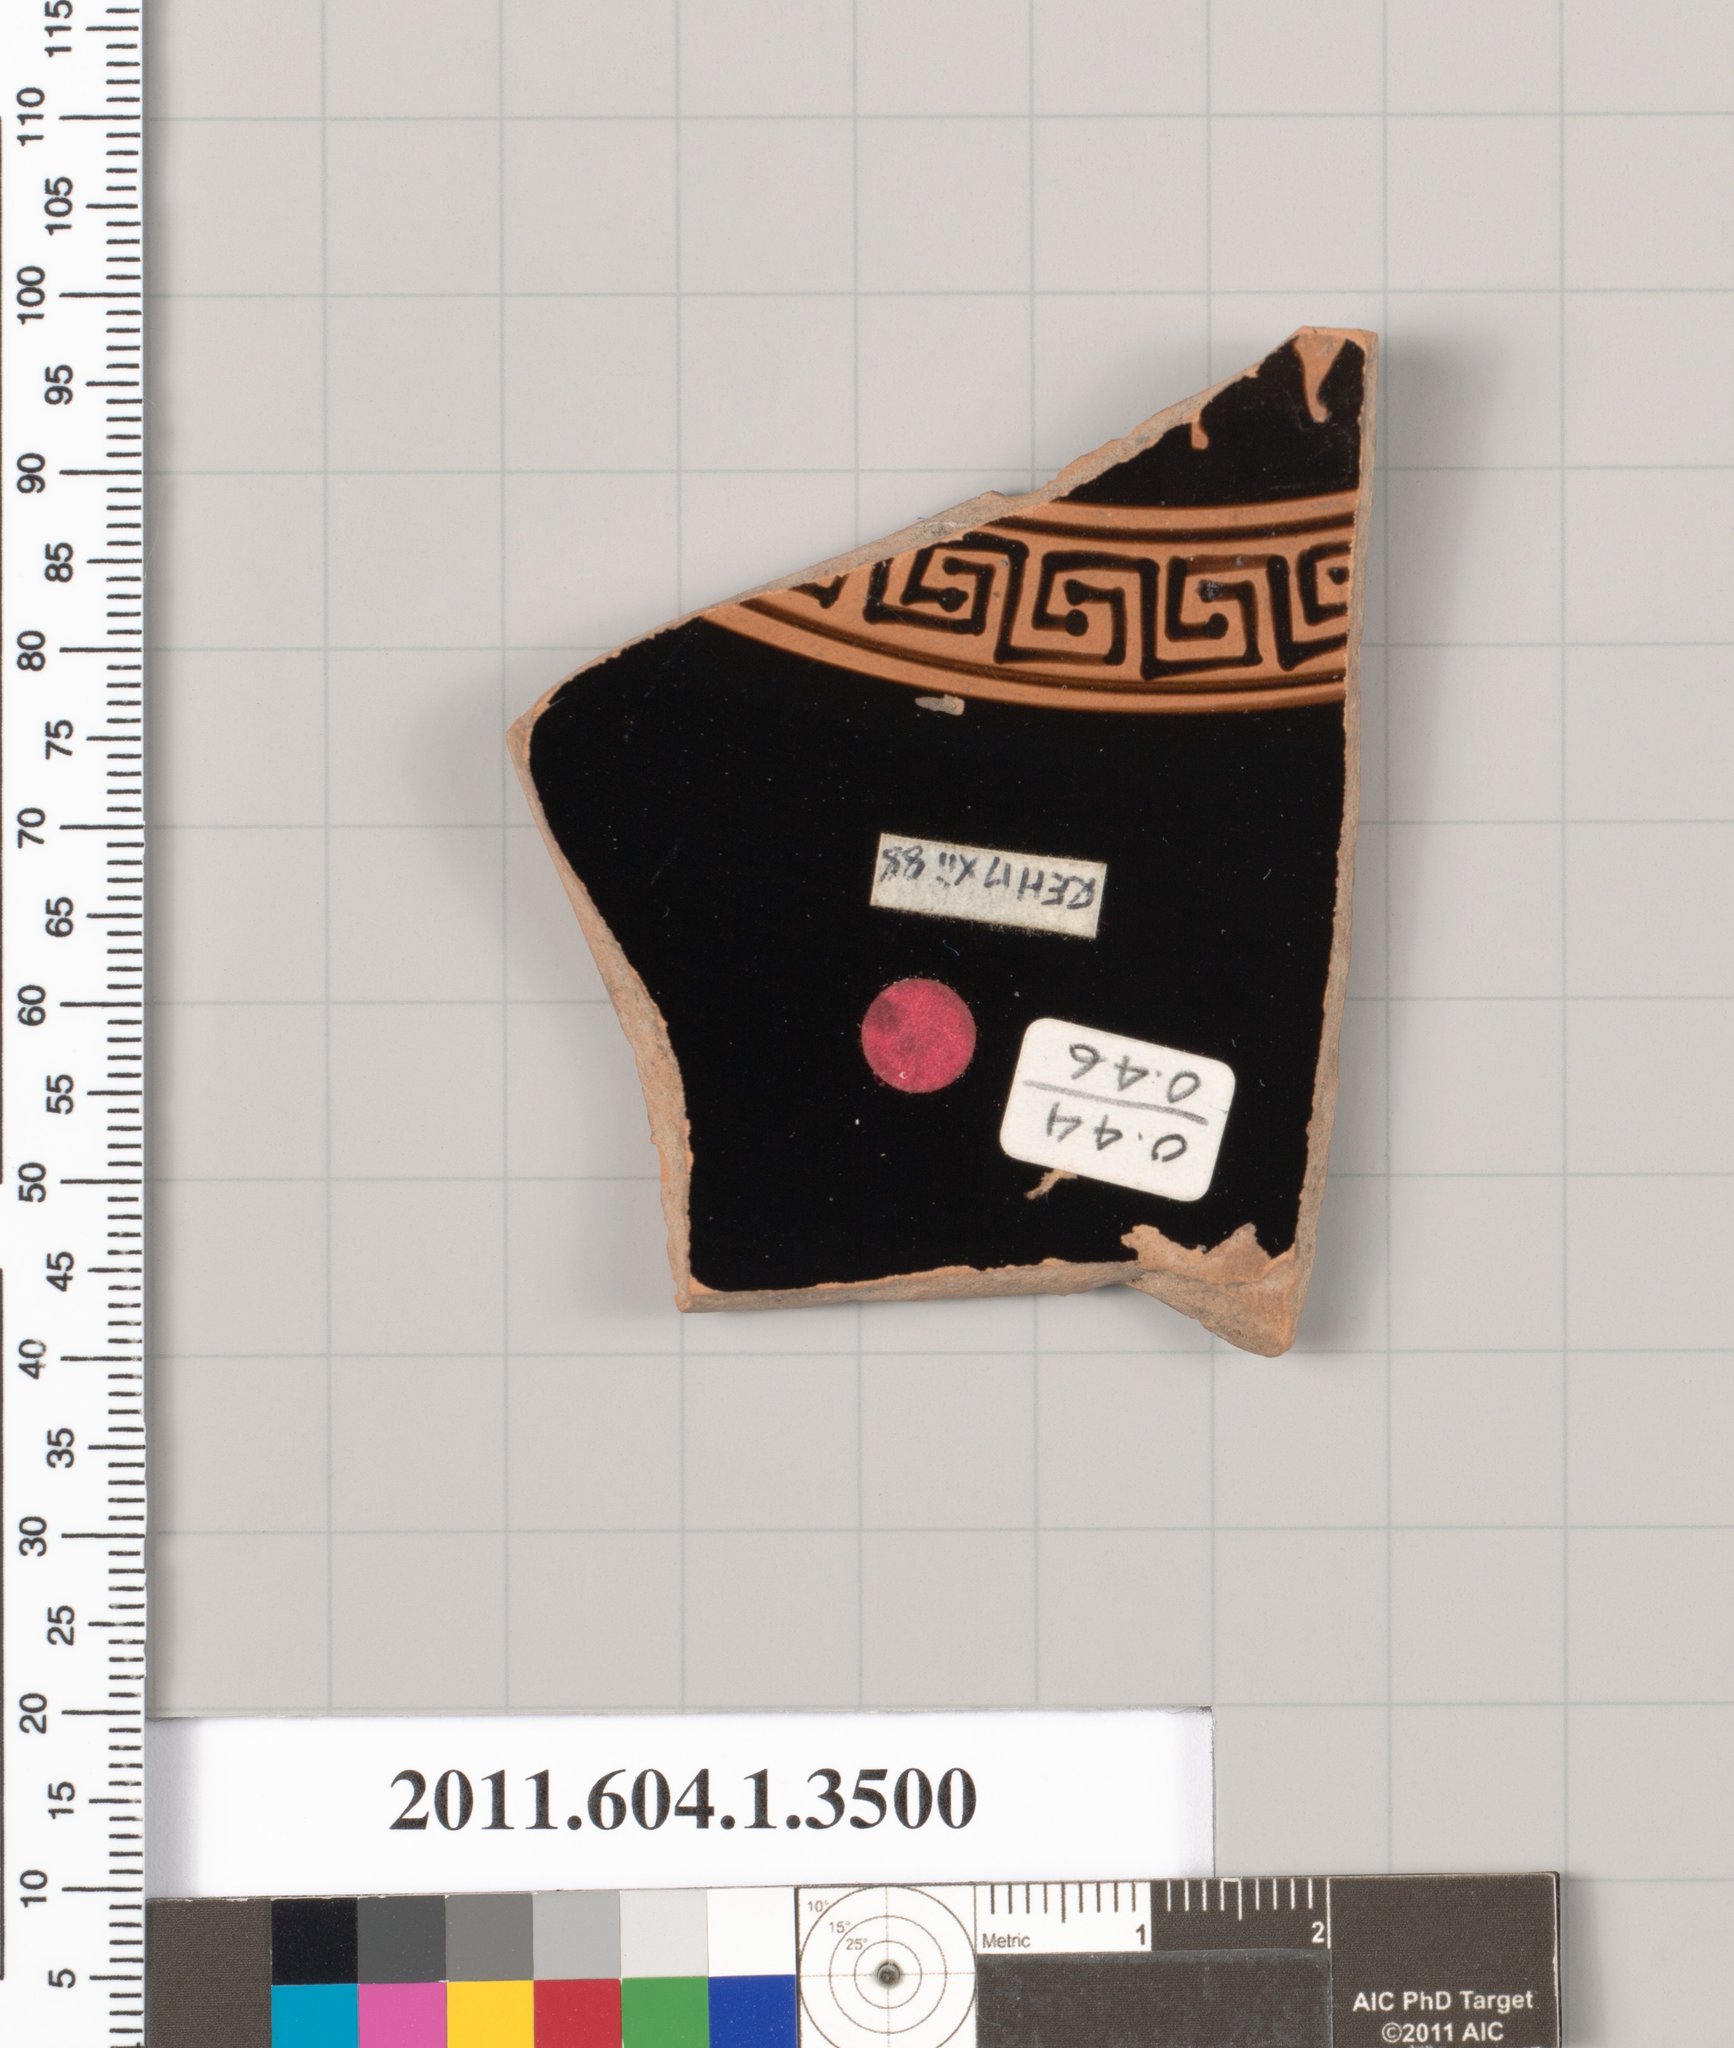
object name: kylix fragment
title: Terracotta fragment of a kylix (drinking cup)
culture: greek, attic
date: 490-480 BCE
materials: terracotta